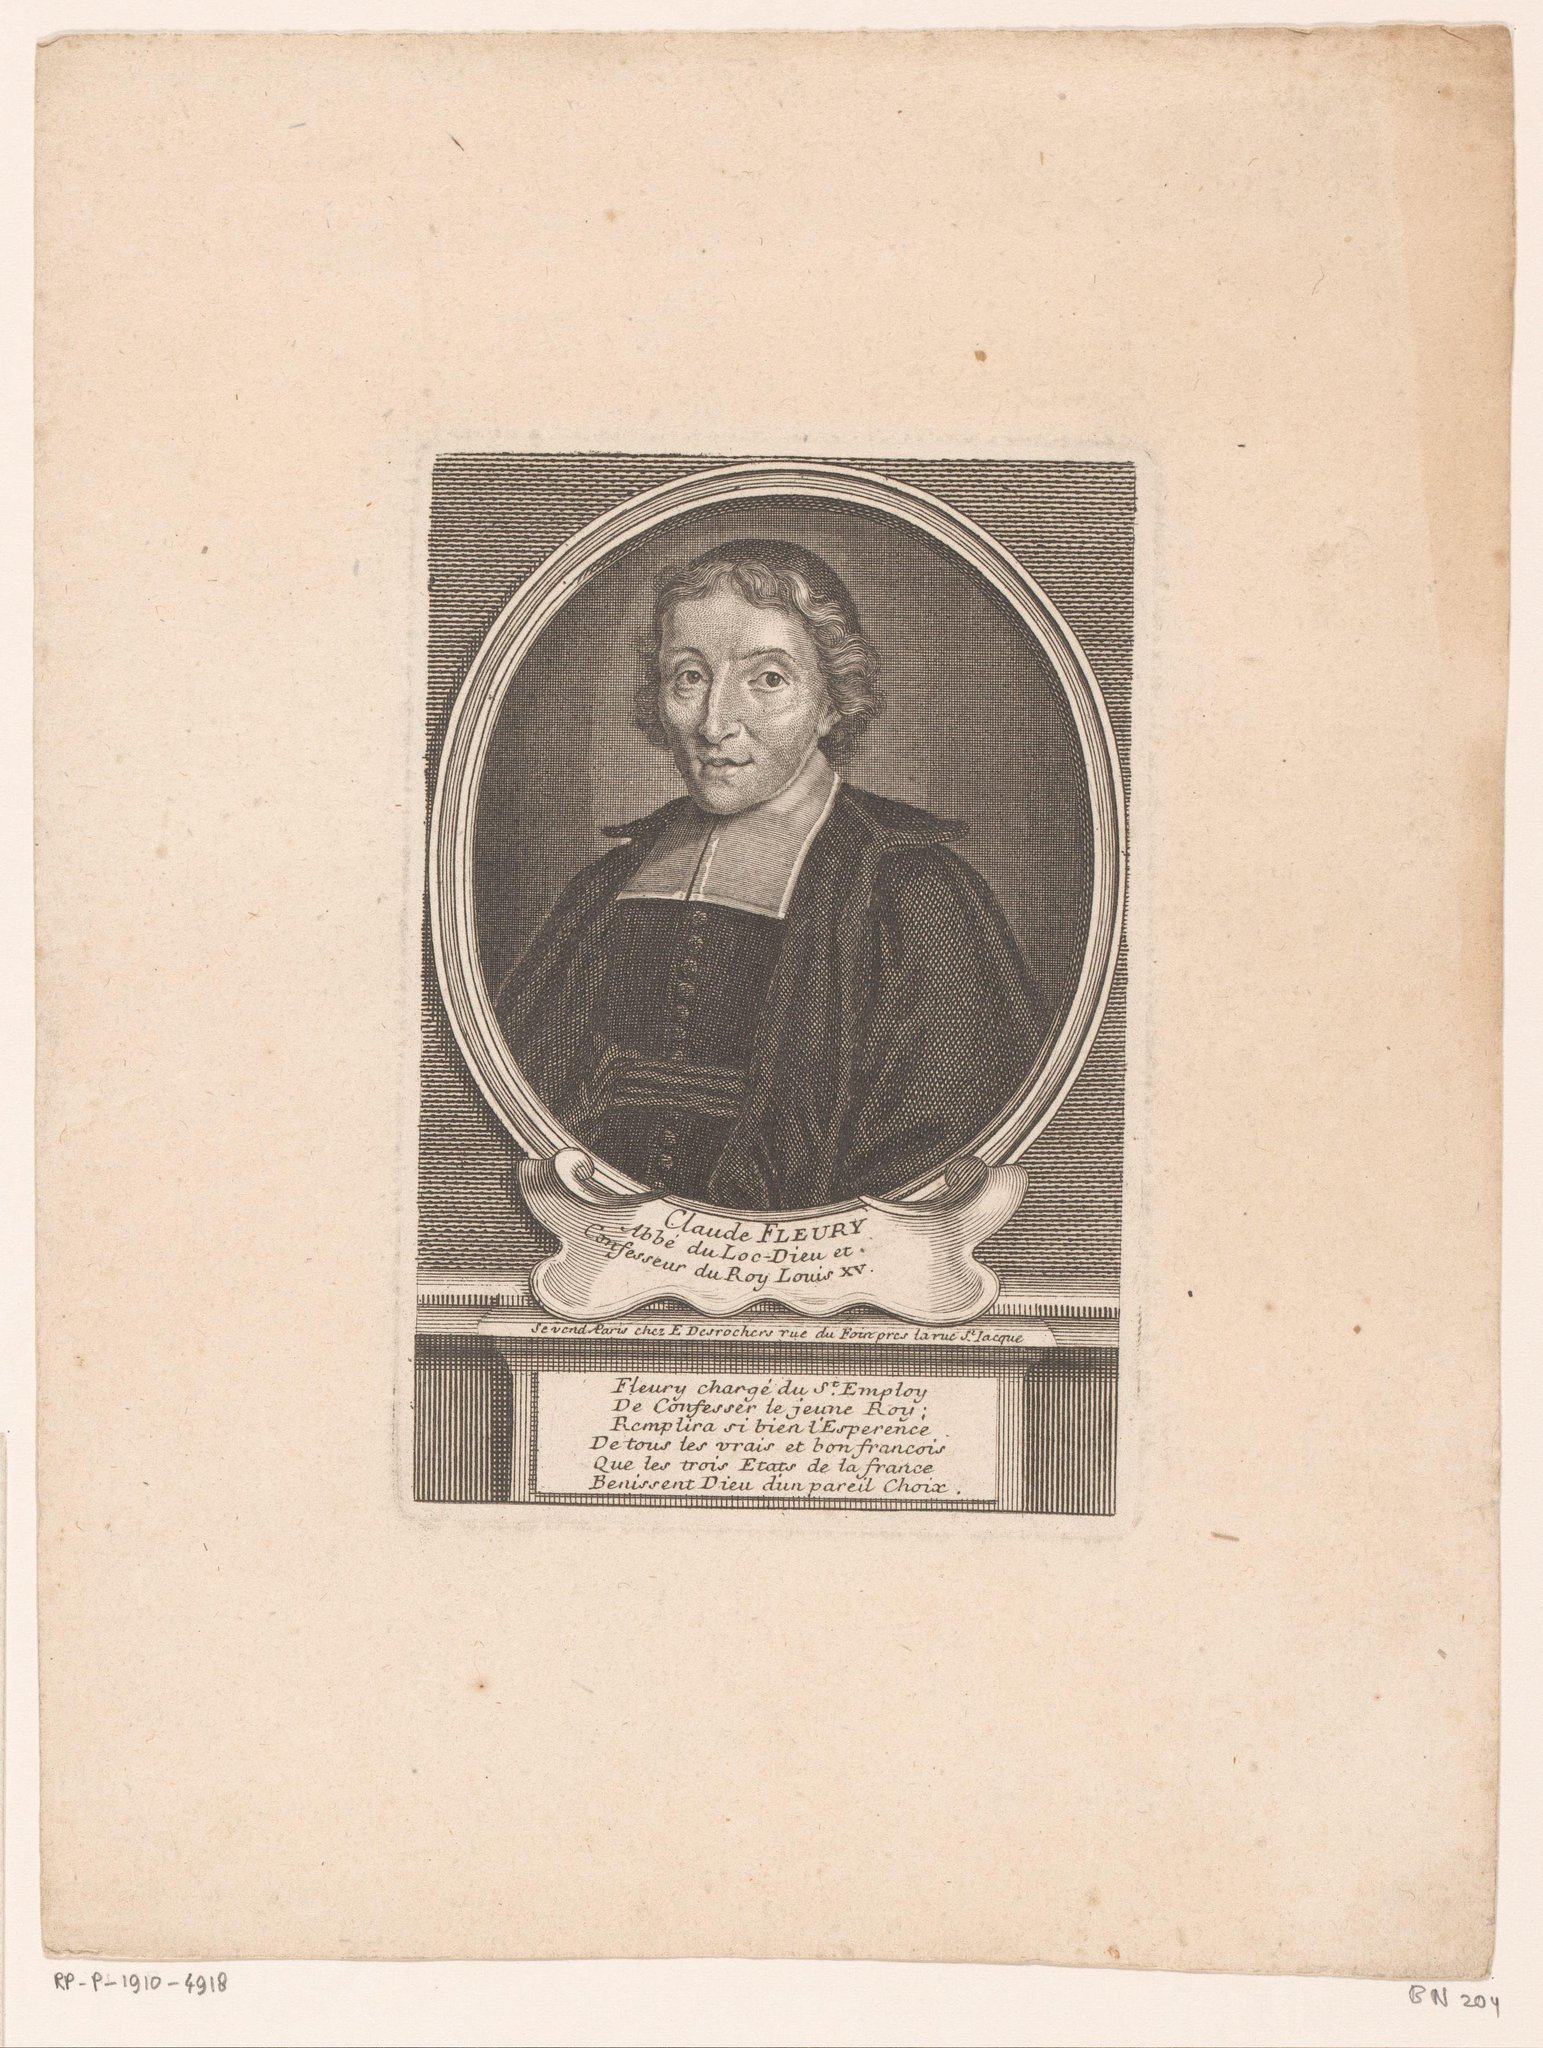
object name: print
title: Verzameling portretten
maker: étienne desrochers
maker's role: print maker, publisher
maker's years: 1668-1741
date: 1726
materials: paper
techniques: engraving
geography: paris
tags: paris, theologian, historical persons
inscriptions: collector's mark: Lugt 2228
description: Behoort waarschijnlijk tot een serie portretten, grotendeels door Etienne Desrochers, getiteld: 'Recueil de portraits de personnes qui se sont distinguées tant dans les Armes que dans Belles-Lettres et les Arts, comme aussi la famille royale de France et autres cours étrangères'. De serie werd initieel uitgegeven door Desrochers en aangekondigd in 'Mercure' in mei 1726, p. 985. Echter was Desrochers reeds enkele jaren eerder begonnen met het uitgeven van de serie. Na de dood van Desrochers werd de serie voortgezet door Gilles Edme Petit. Een latere staat werd uitgegeven door Jean François Daumont in Parijs.